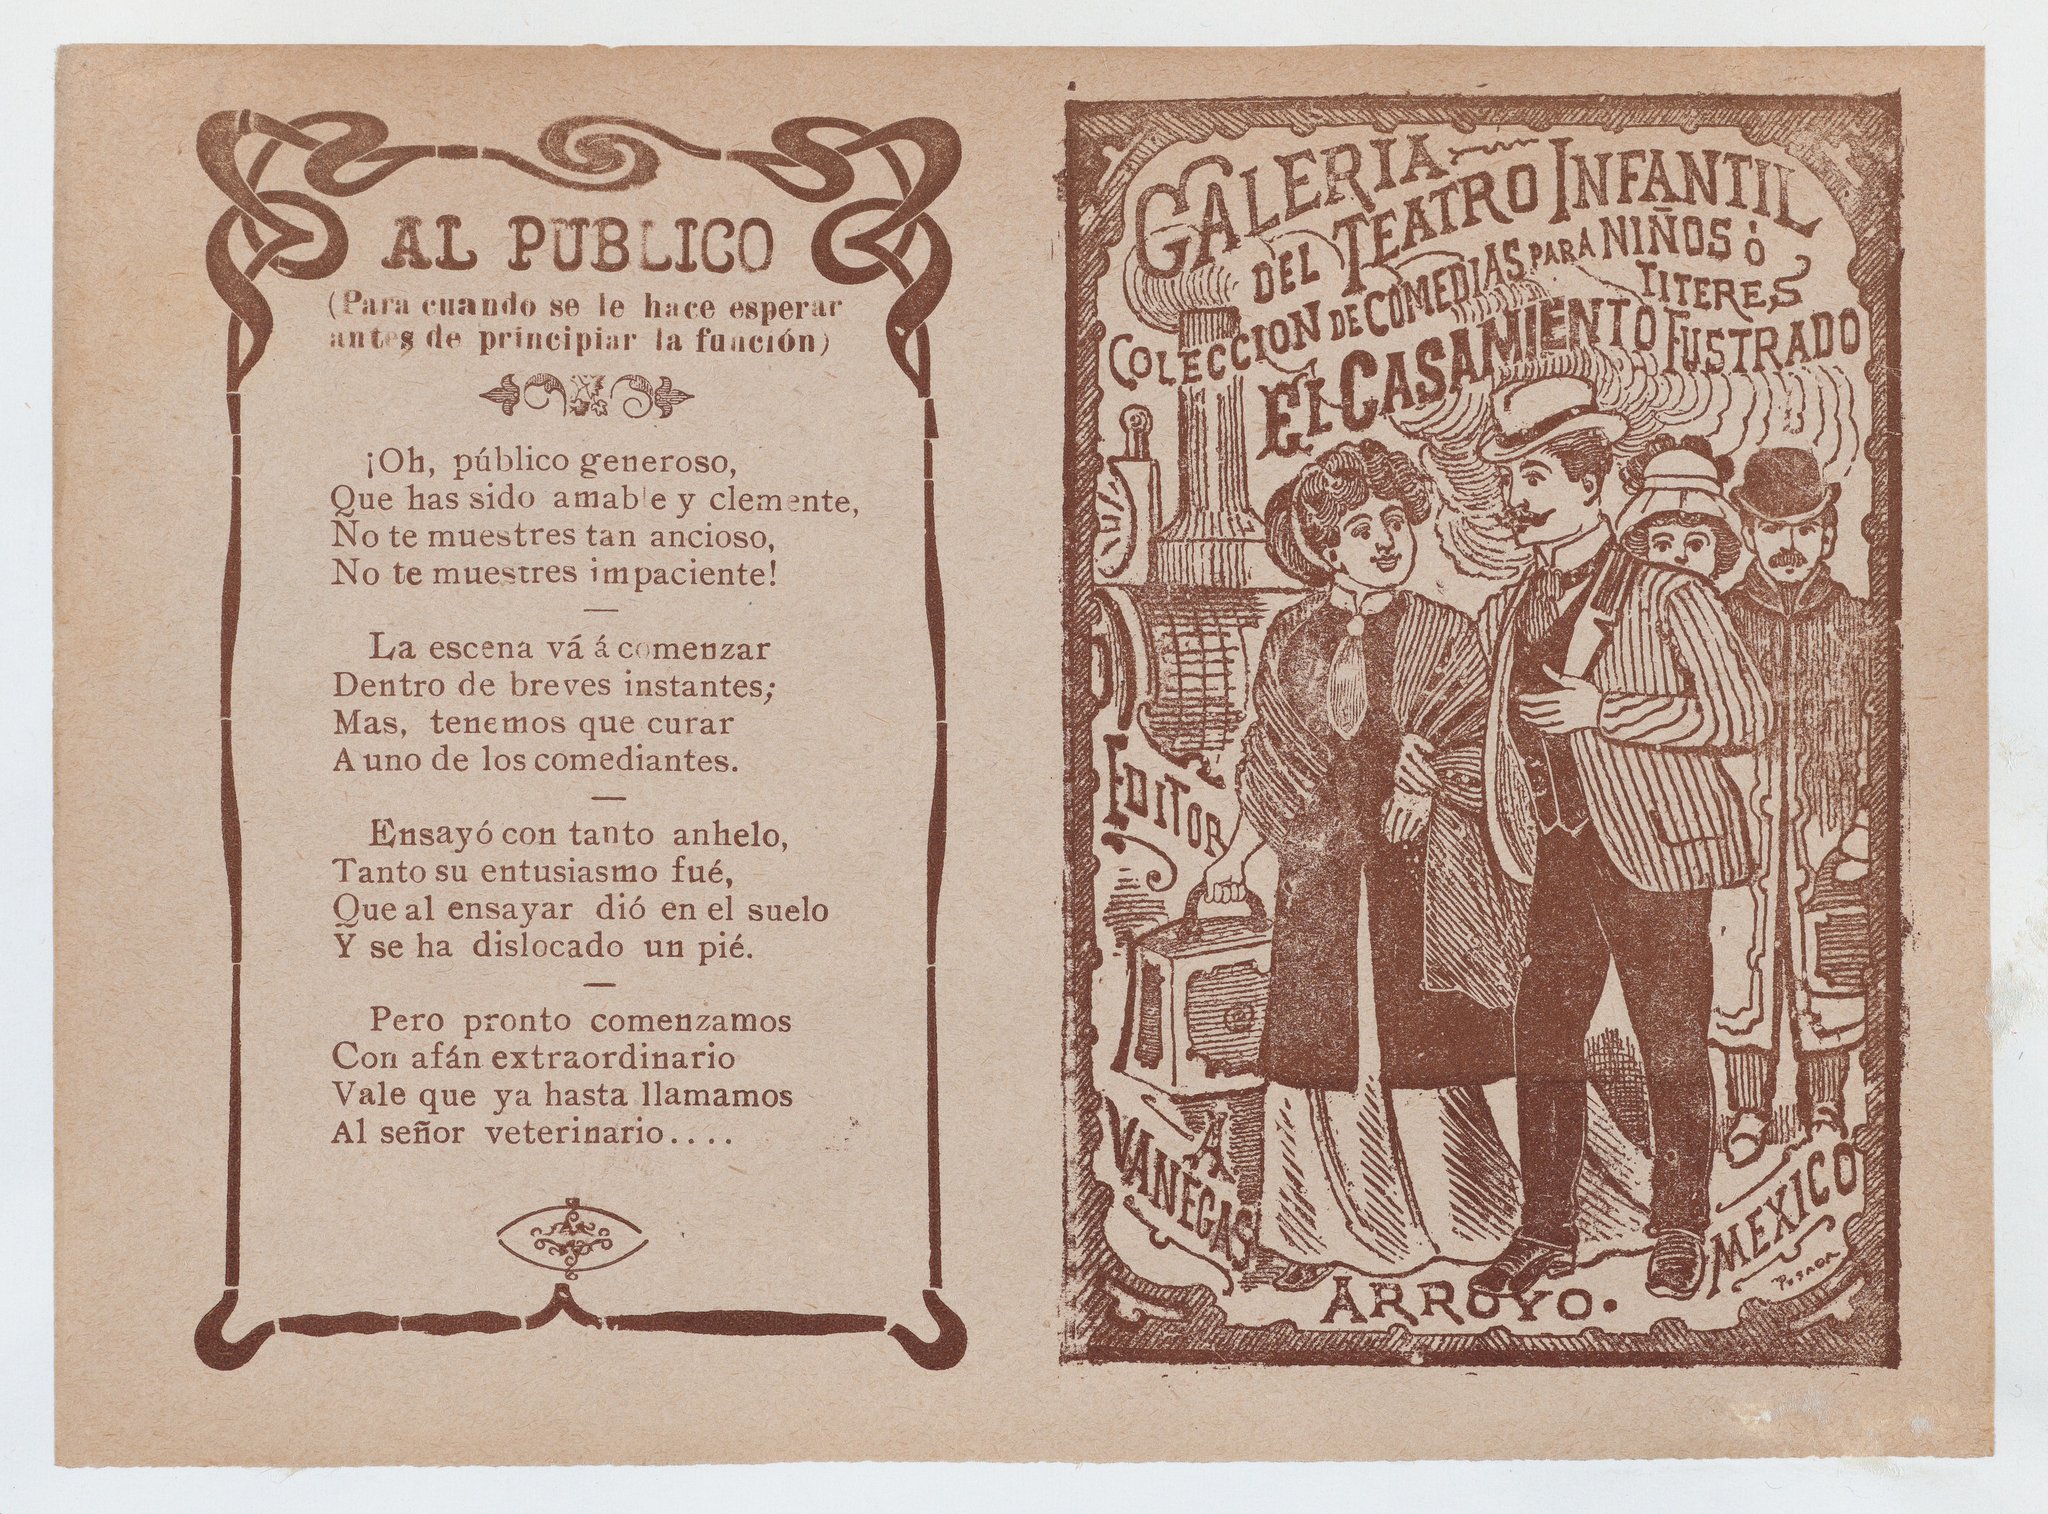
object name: print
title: Cover for 'El Casamiento Fustrado', a man and woman walking arm in arm, a train in the background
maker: josé guadalupe posada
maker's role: artist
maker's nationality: mexican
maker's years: 1852-1913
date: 1890-1910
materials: ink, metal, paper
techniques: engraving, letterpress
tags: men,women